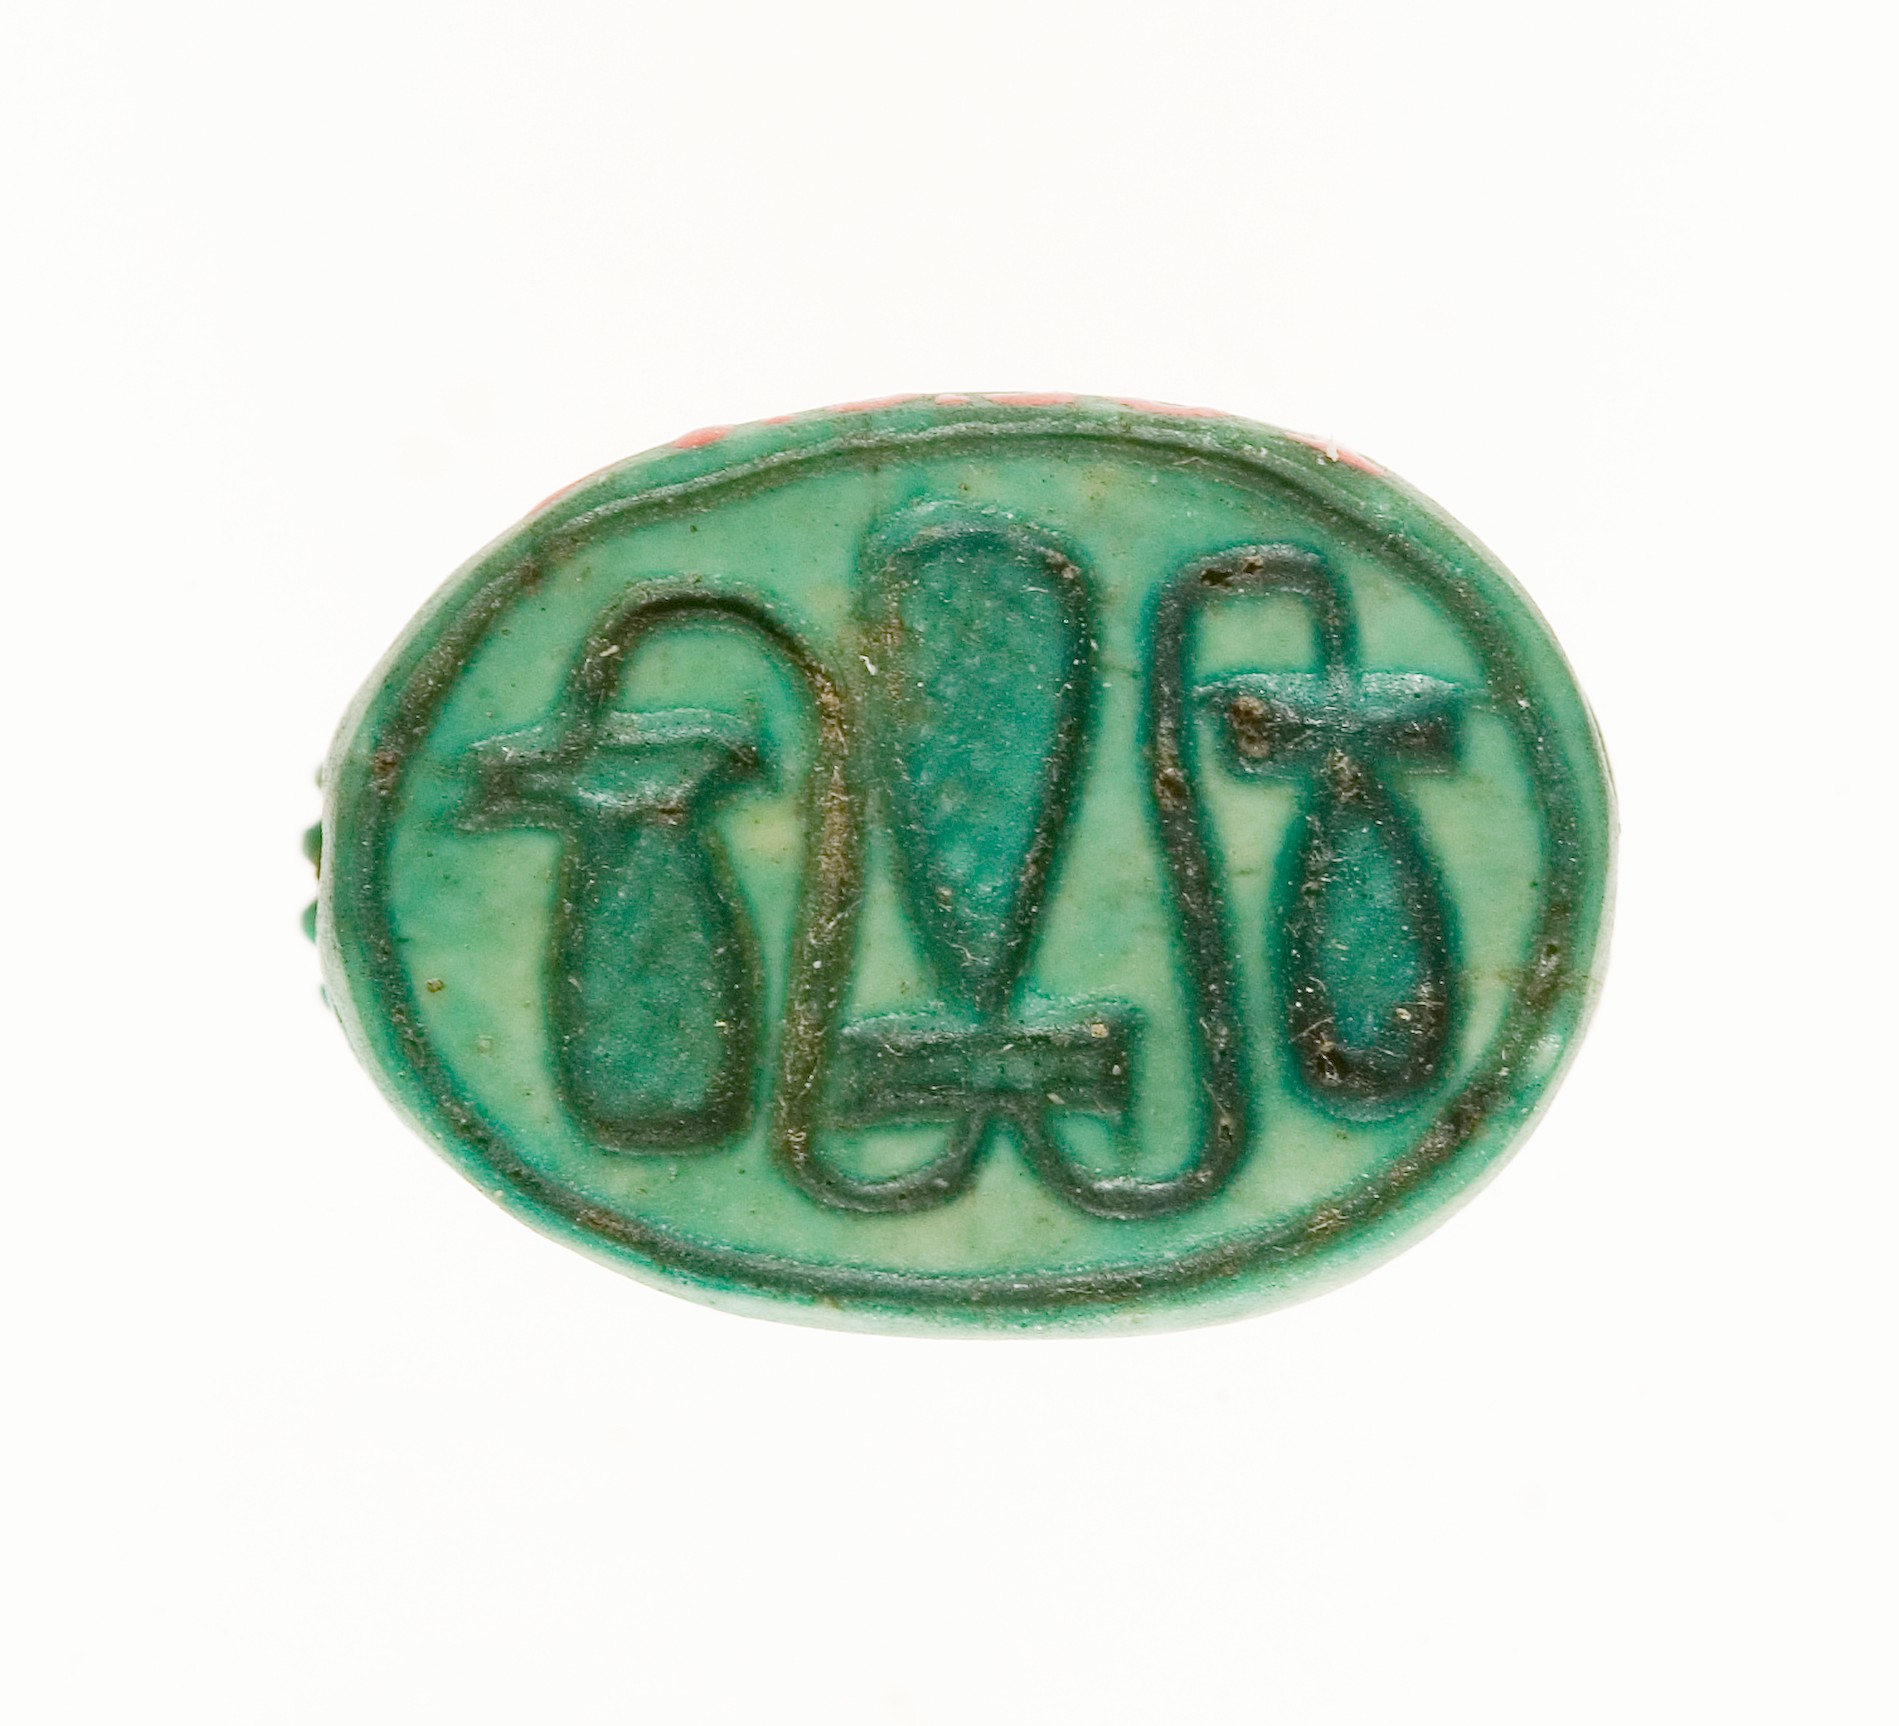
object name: scarab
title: Scarab Inscribed with a Geometric Pattern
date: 1479-1458 BCE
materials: stone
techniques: glazing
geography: egypt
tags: hieroglyphs,scarabs